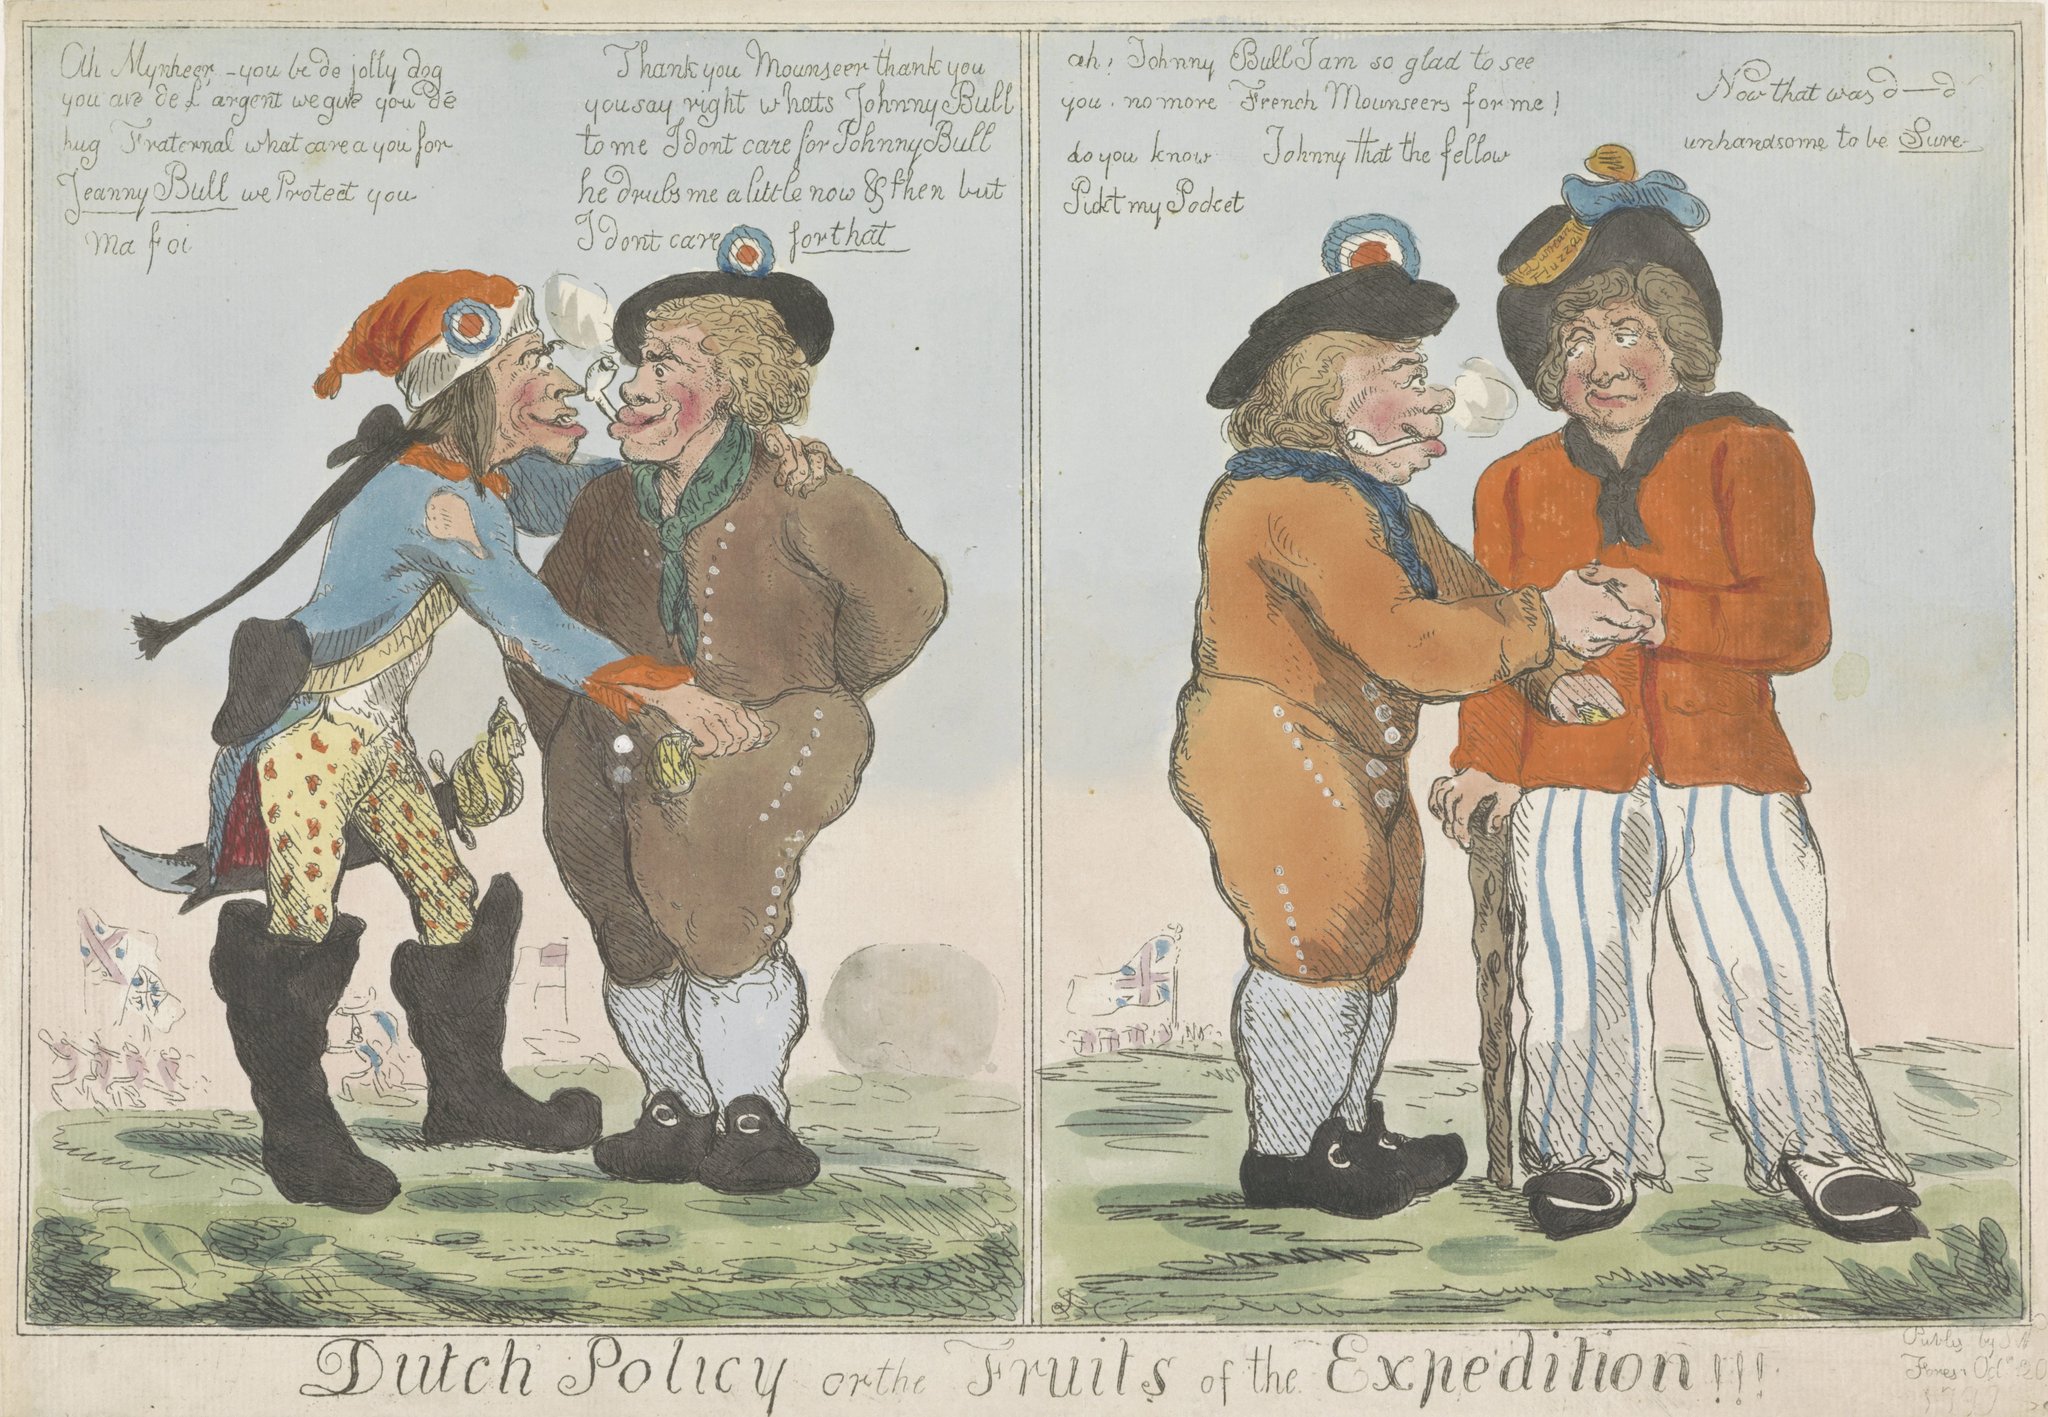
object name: cartoon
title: Dutch Policy or the Fruits of the Expedition!!!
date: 1799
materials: paper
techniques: etching, hand coloring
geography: london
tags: brits-russische expeditie naar noord-holland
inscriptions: collector's mark: Lugt 2228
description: Engelse spotprent in twee helften. Links een Fransman die de vriendschap met de Hollander verklaart en zijn zak rolt. Rechts verklaart de Hollander zijn vriendschap aan de Engelsman en rolt zijn zak. Naar aanleiding van de Brits-Russische expeditie naar Noord-Holland in 1799.